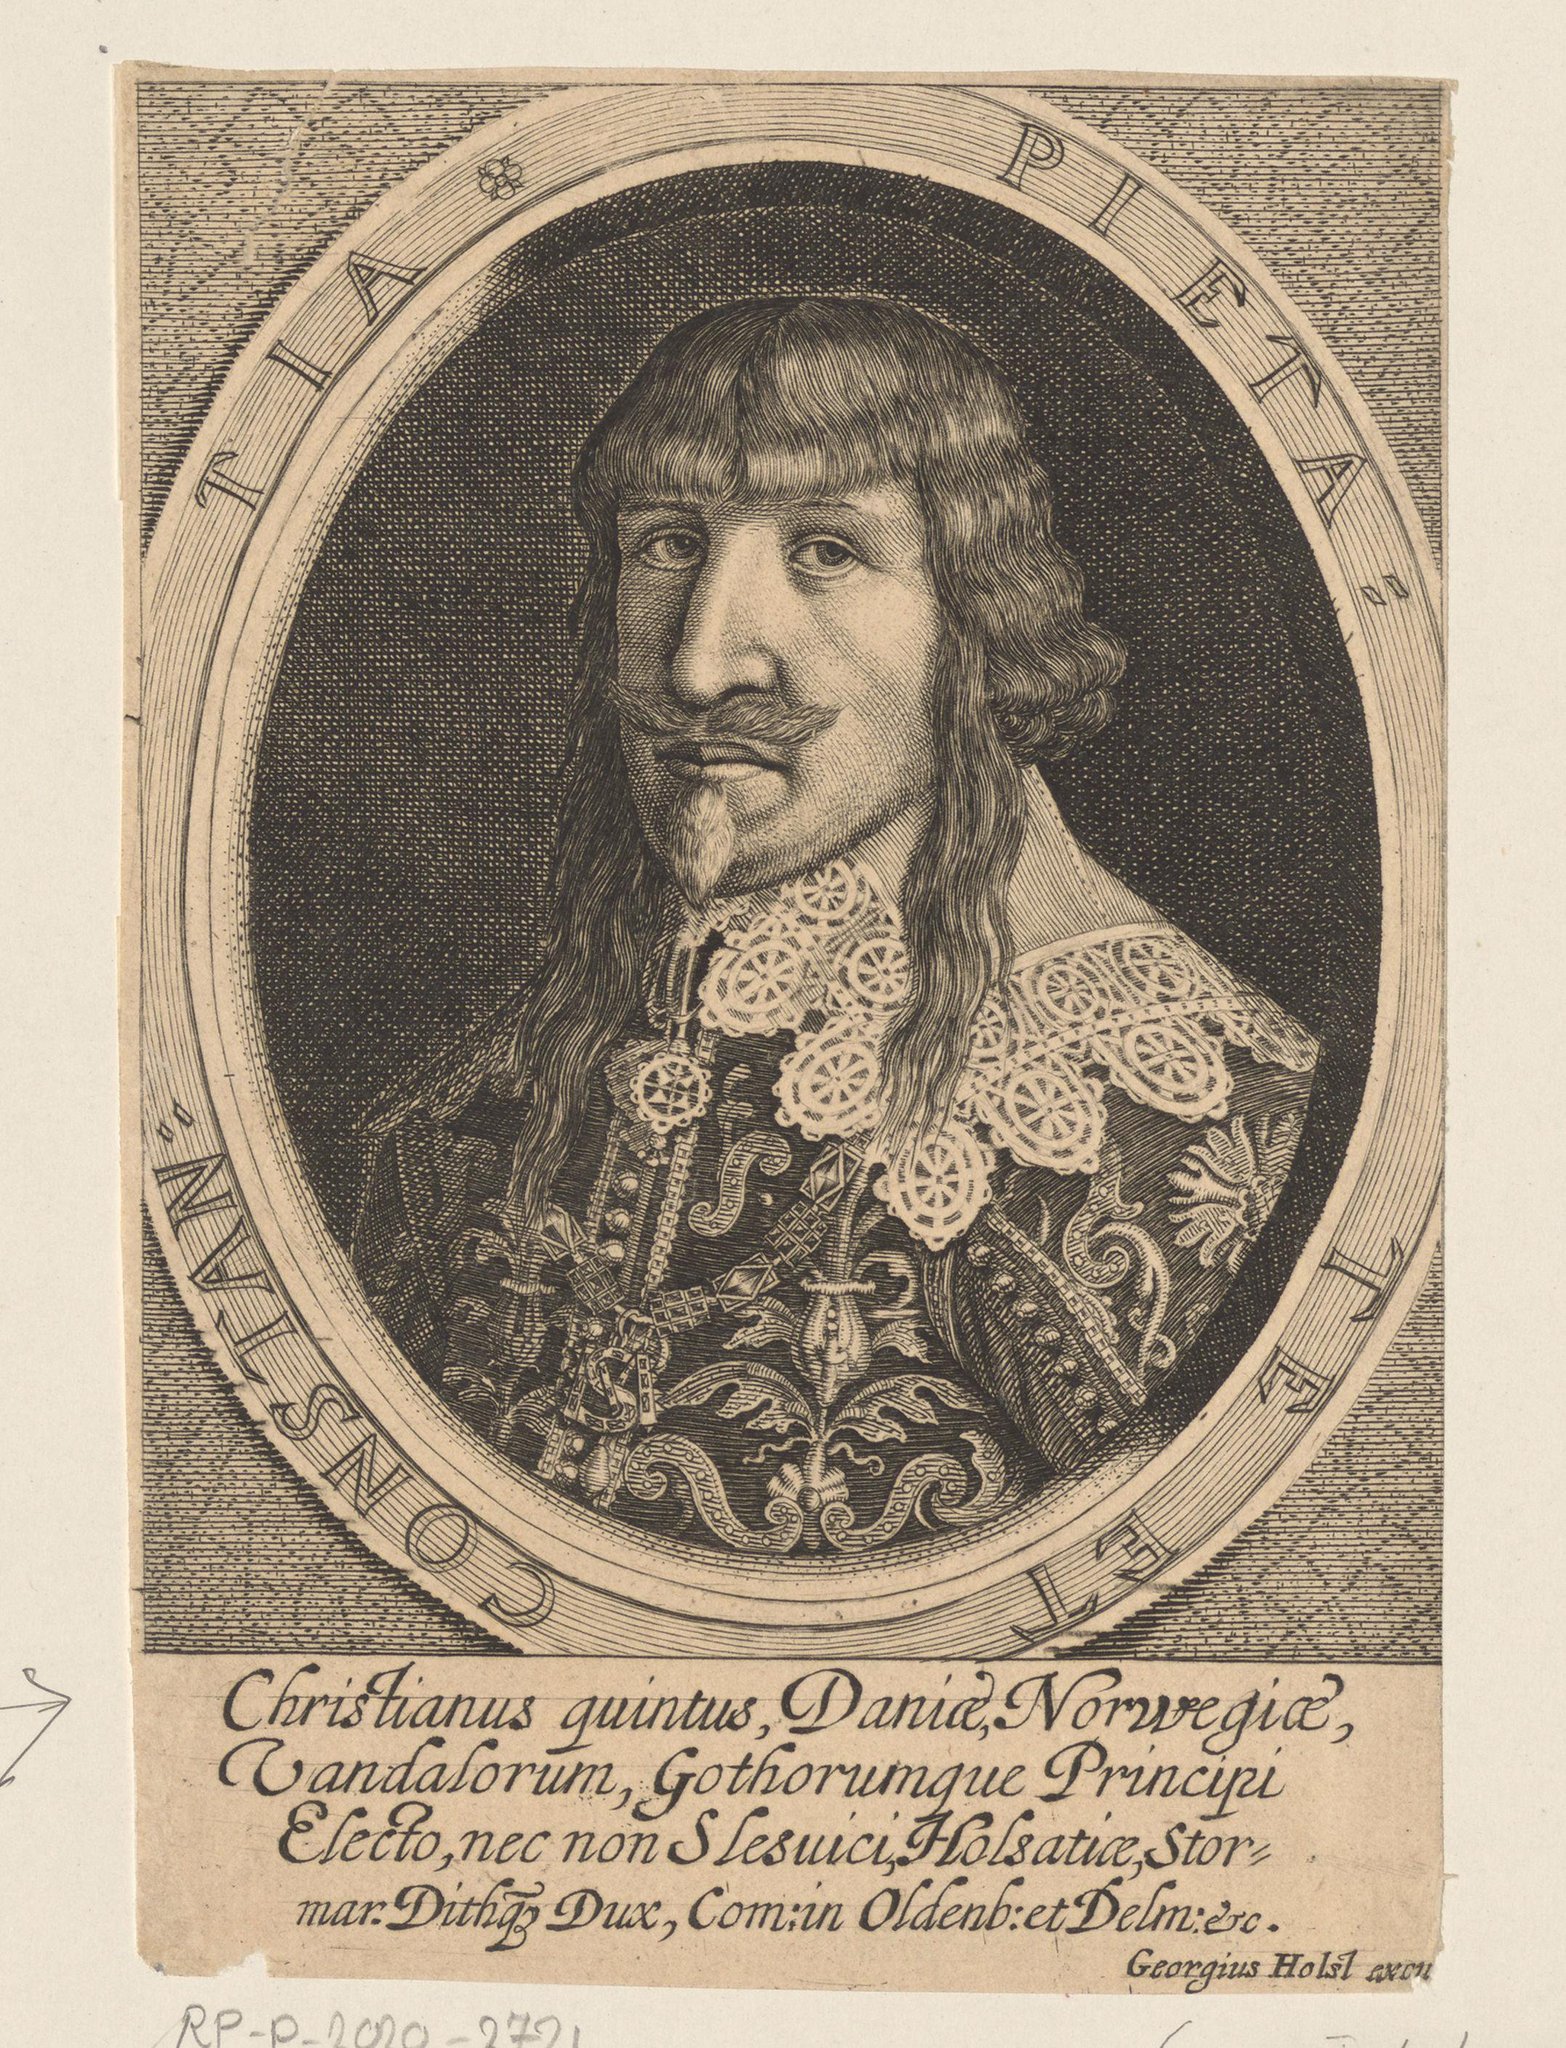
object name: print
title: Portret van Christiaan V, koning van Denemarken en Noorwegen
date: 1643-1664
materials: paper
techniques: engraving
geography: copenhagen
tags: historical persons, king